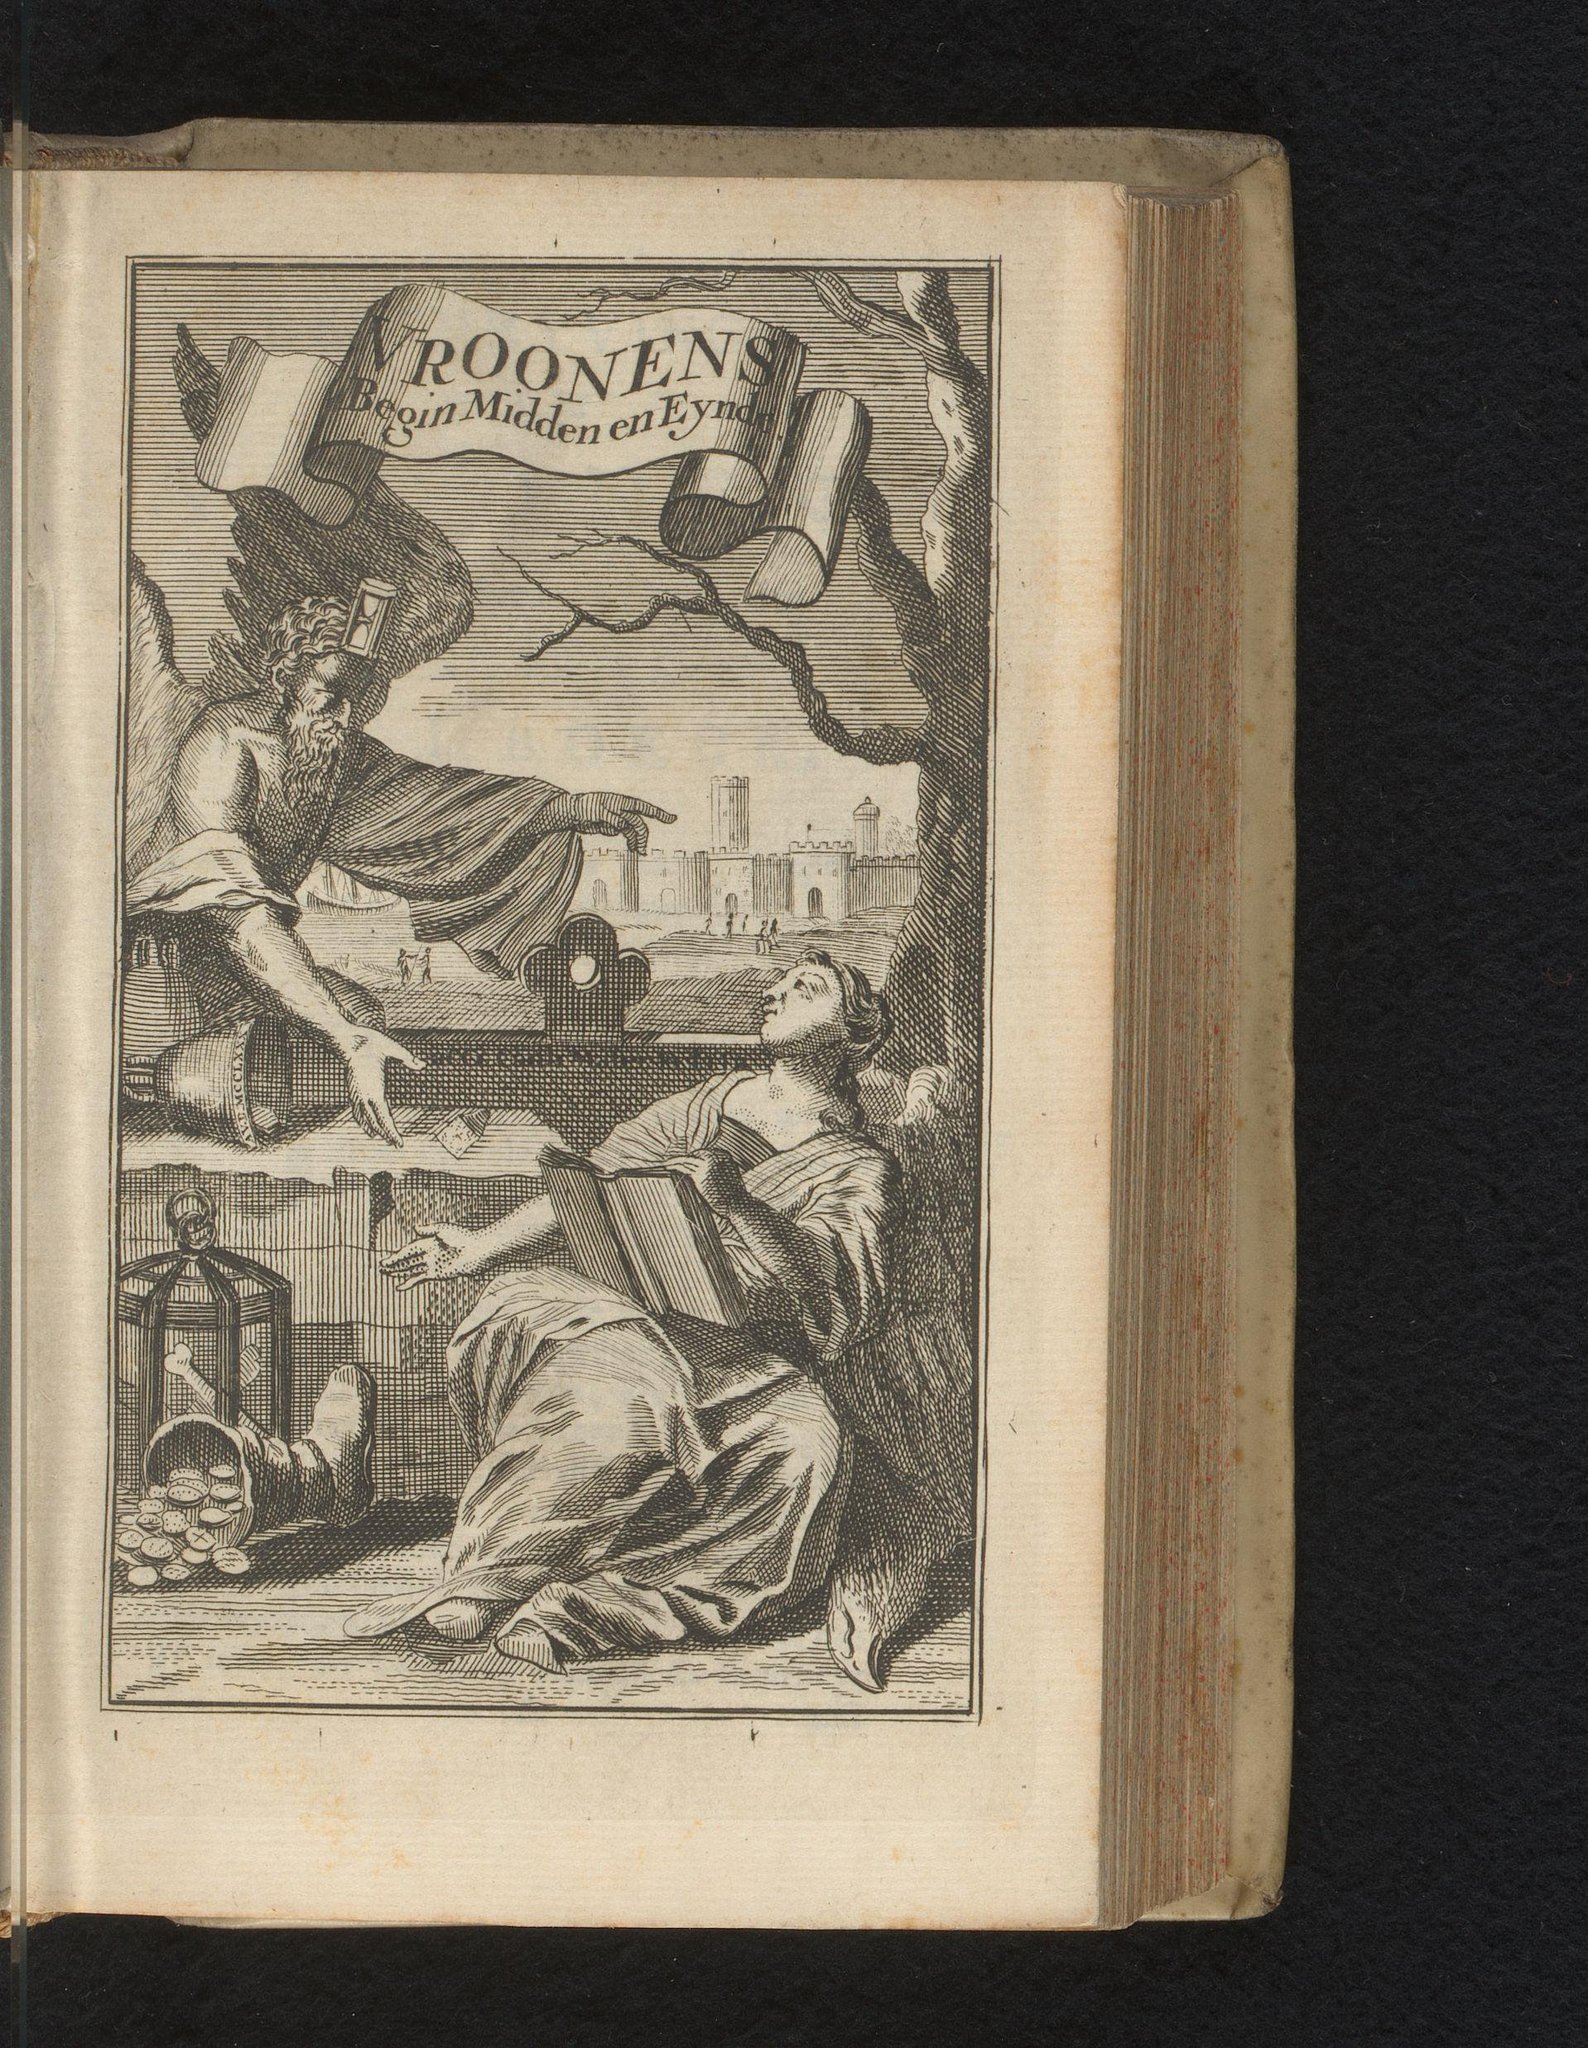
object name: print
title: Vroonens Begin Midden en Eynde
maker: pieter van den berge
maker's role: draughtsman, print maker, printer, publisher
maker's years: 1659-1737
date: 1700-1702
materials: paper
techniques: etching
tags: 'historia'; 'historia' (ripa), father time, man with wings and scythe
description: Illustratie in: H. Soeteboom, Oud-heden van Zaan-land, Stavoren, Vronen en Waterland : deze laatste druk ... met nodige aanteekeningen, figuren, en een landkaart verrykt / Vroonens Begin Midden en Eynde, W. Linnig van Koppenol, Amsterdam 1702, dl. 2, titelprent.